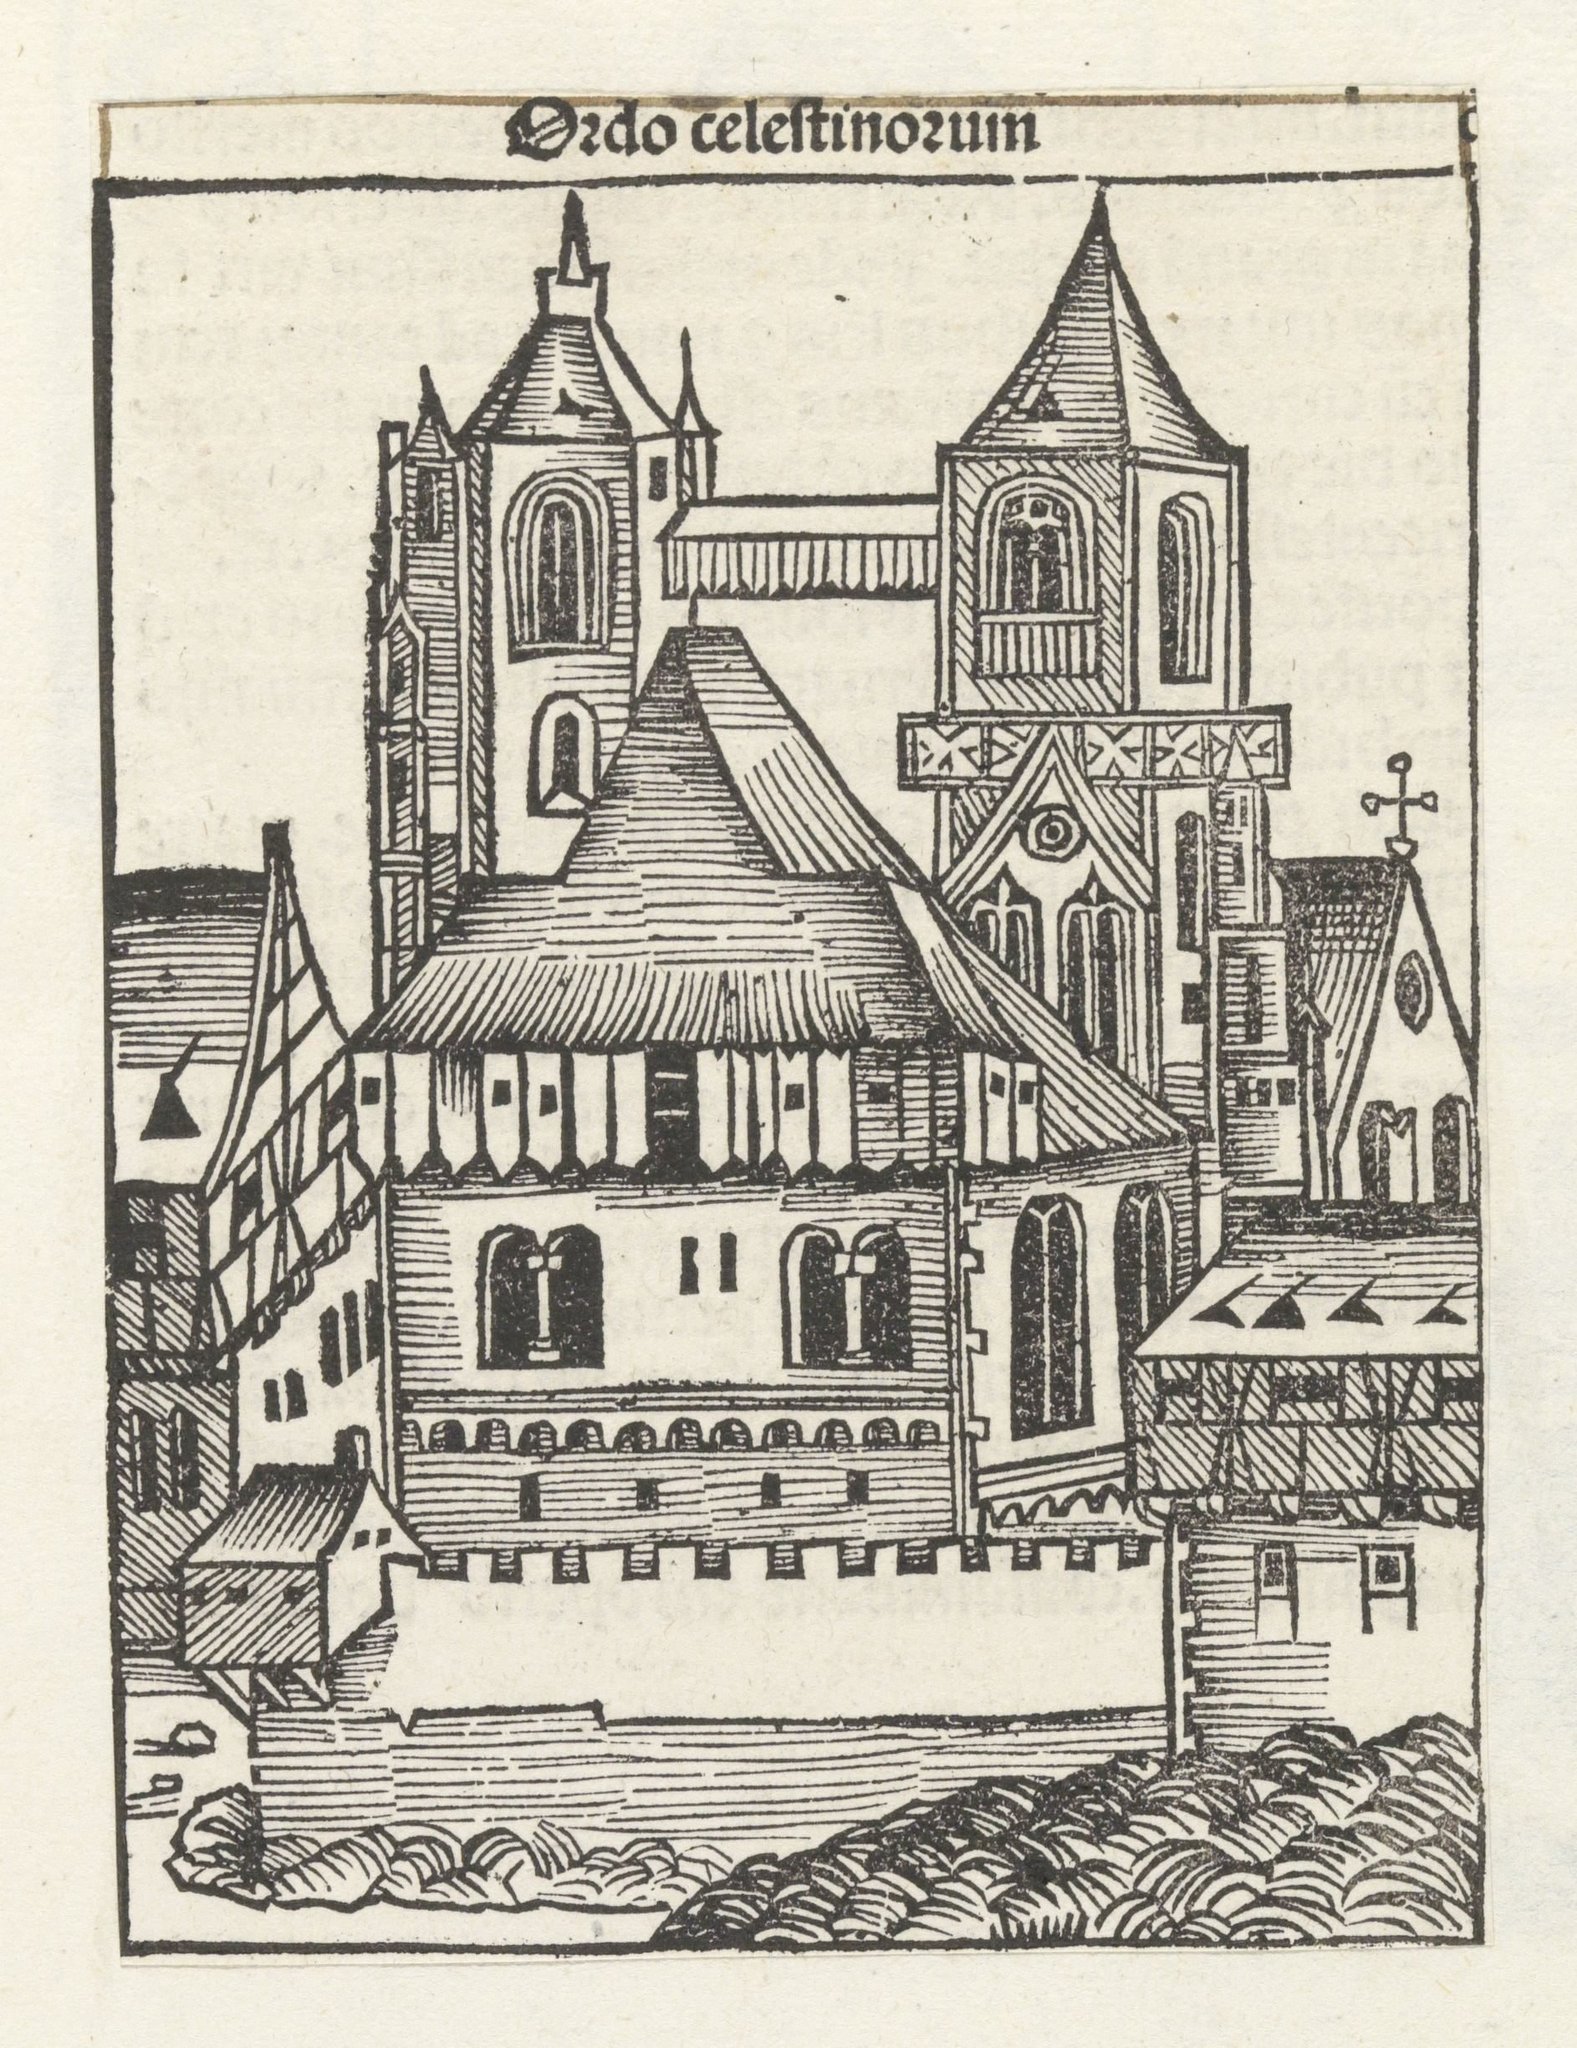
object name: print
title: Orde van de Celestijnen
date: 1493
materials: paper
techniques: letterpress printing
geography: nuremberg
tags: abbey, monastery, convent ~ roman catholic church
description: De houtsnede wordt herhaaldelijk gebruikt als boekillustratie in de Liber Chronicarum (of Neurenbergkroniek) van Hartmann Schedel, verschenen in het Latijn en Duits in 1493. Zie de Latijnse uitgave, folio 219r.